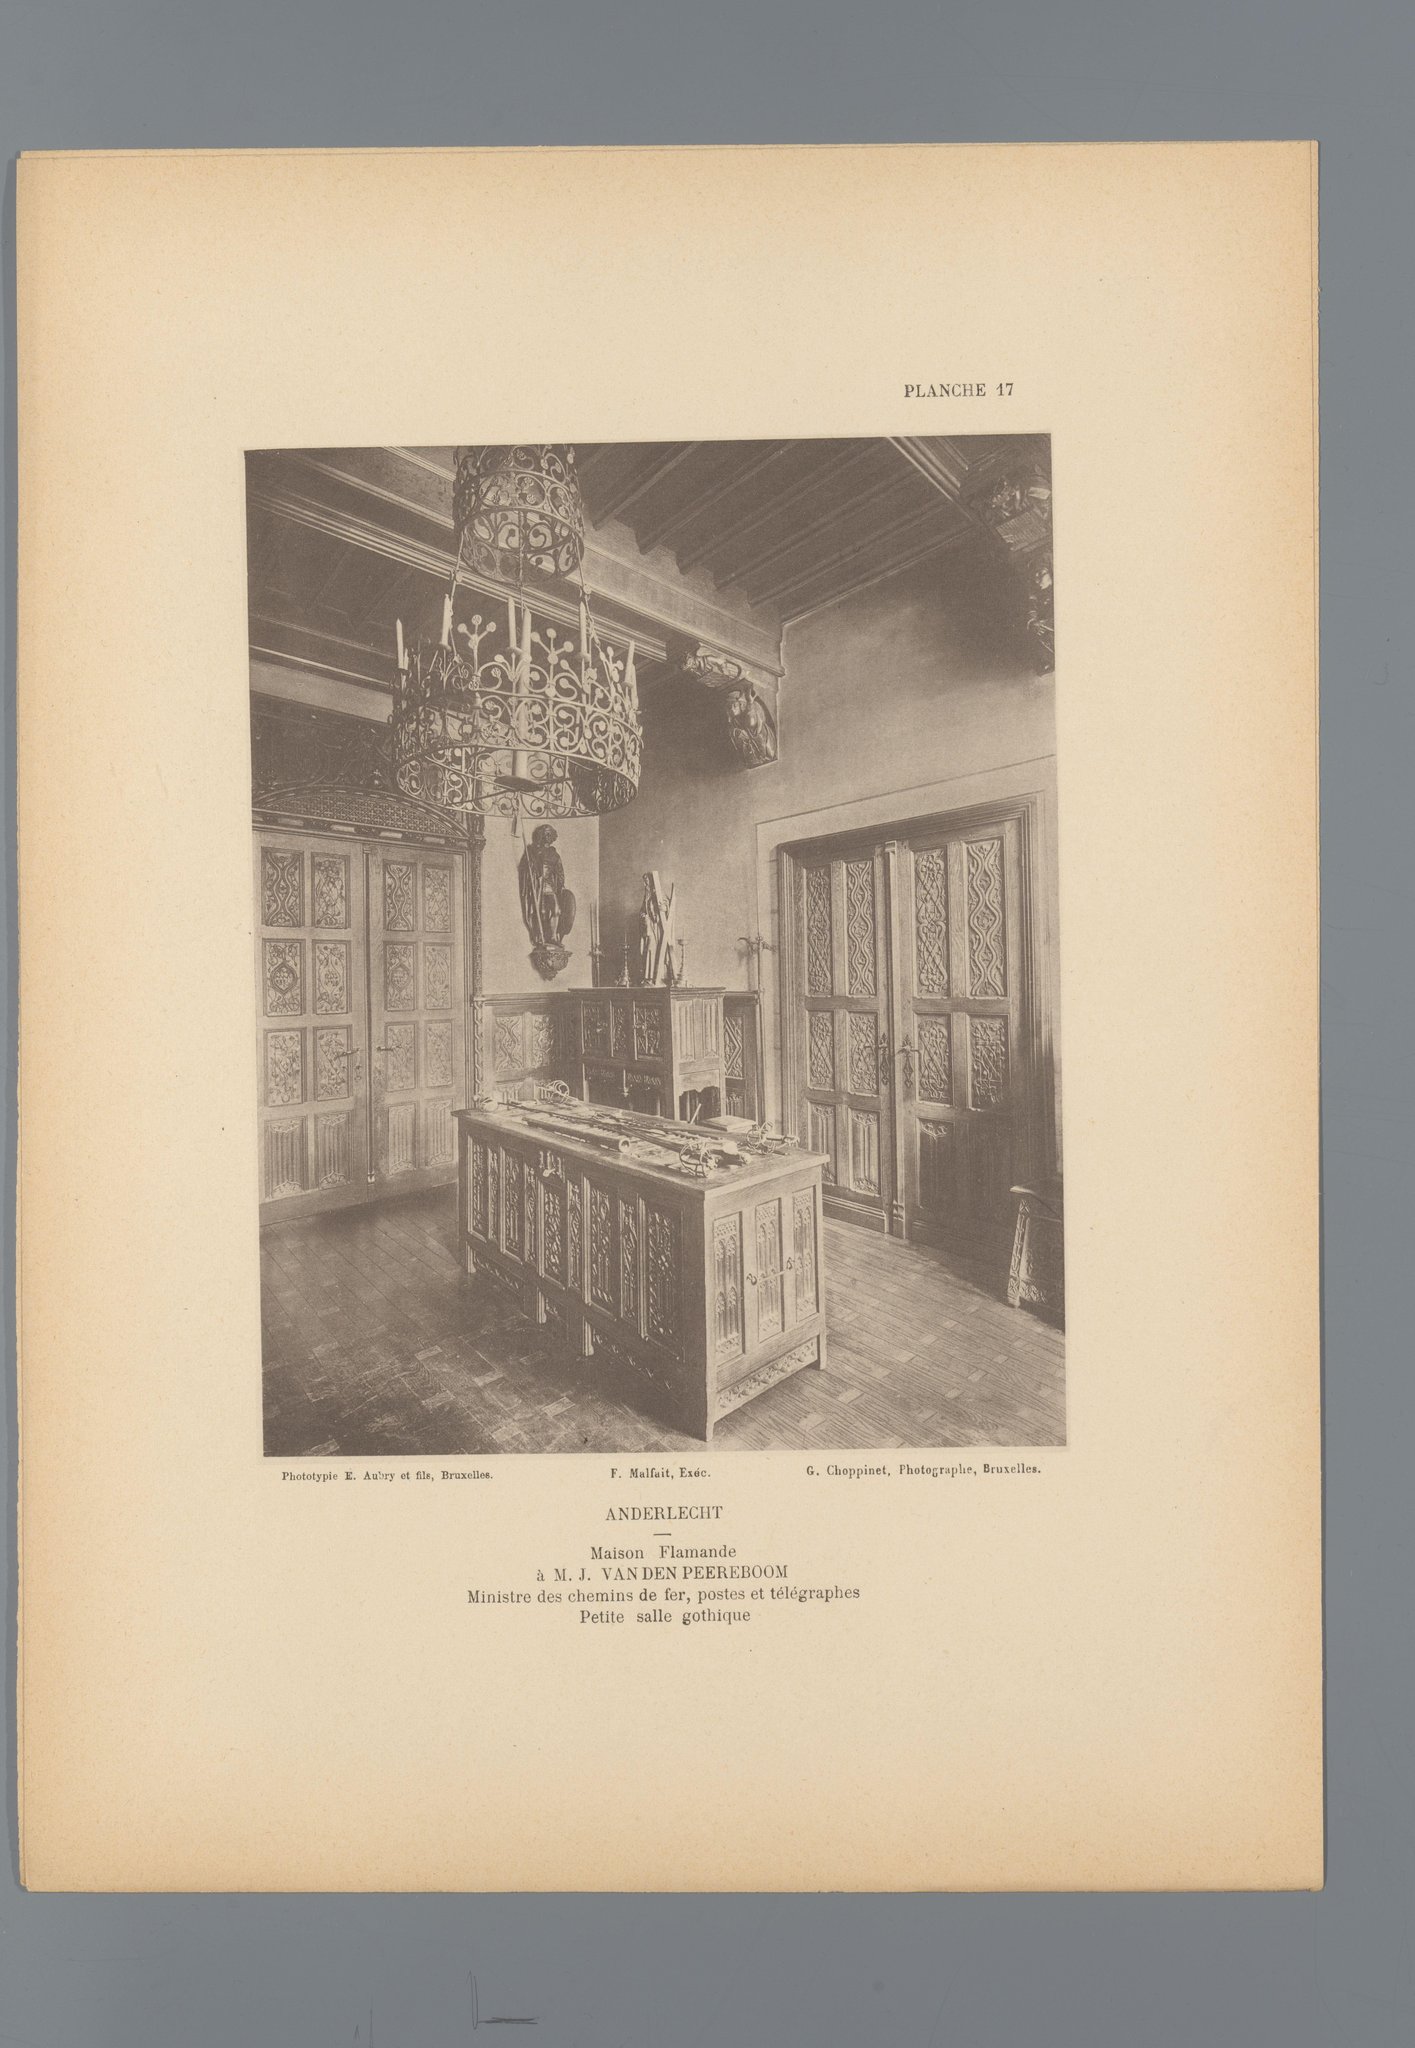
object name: photomechanical print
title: Gezicht op een kleine kamer in gotische stijl in het huis van J. vanden Peereboom in Anderlecht, België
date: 1893-1898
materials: paper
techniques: photograph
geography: brussels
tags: interior of the house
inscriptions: name: ‘F. Malfait, Exéc.’, inscription: ‘Maison Flamande/ à M. J. VAN DEN PEEREBOOM/ Ministre des chemins de fer, postes et télégraphes/ Petite salle gothique’, number: ‘PLANCHE 17’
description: Deze prent maakt deel uit van een omslag met 89 prenten en 5 tekstbladen.